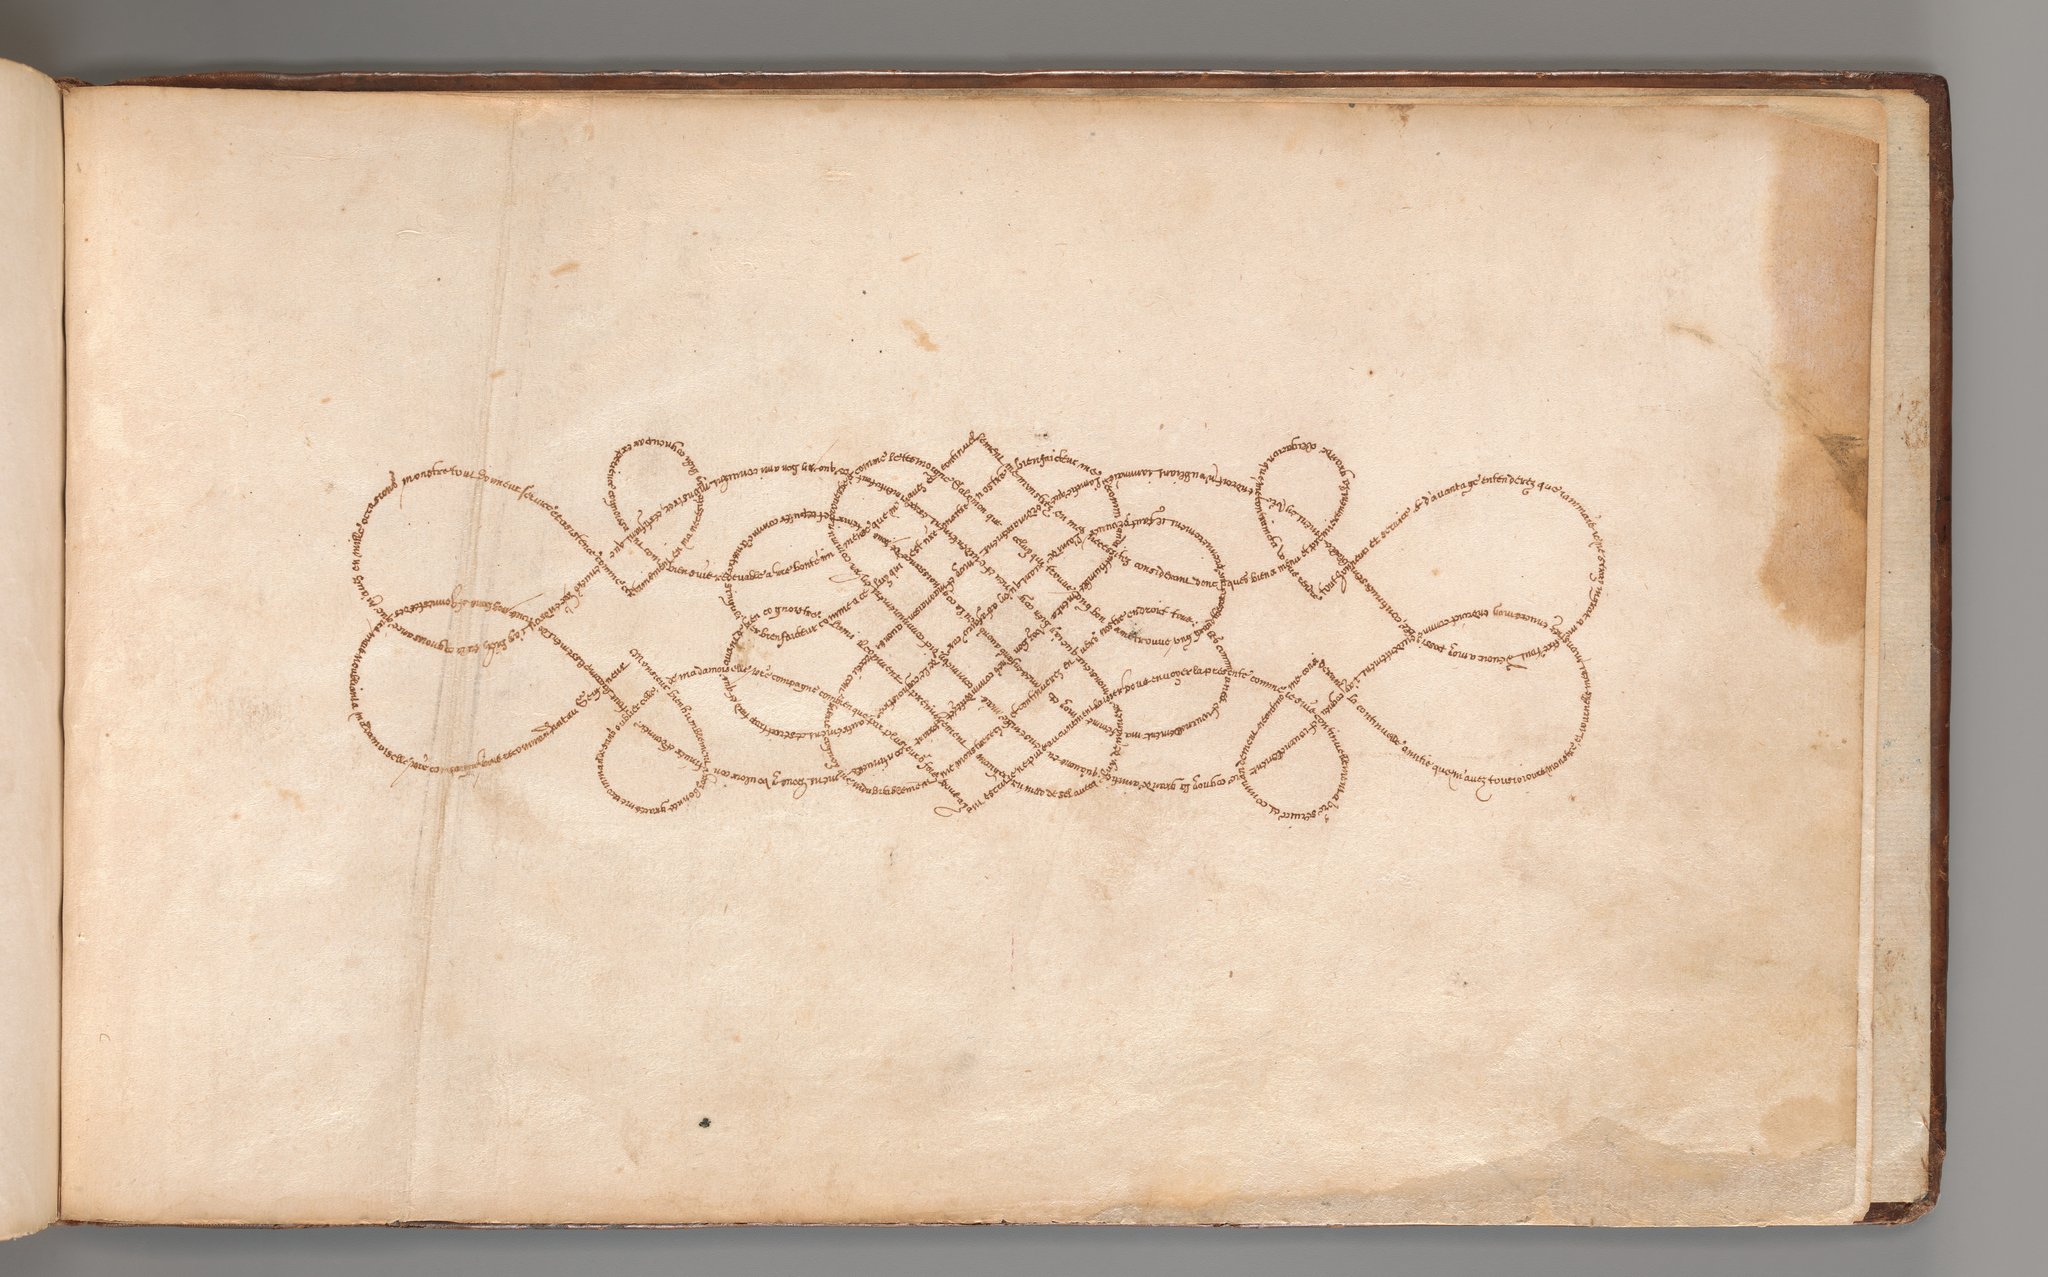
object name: album print ornament architecture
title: Micrographic Design in the Shape of a Knot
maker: Anonymous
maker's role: artist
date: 1601-1633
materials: ink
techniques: pen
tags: ornament